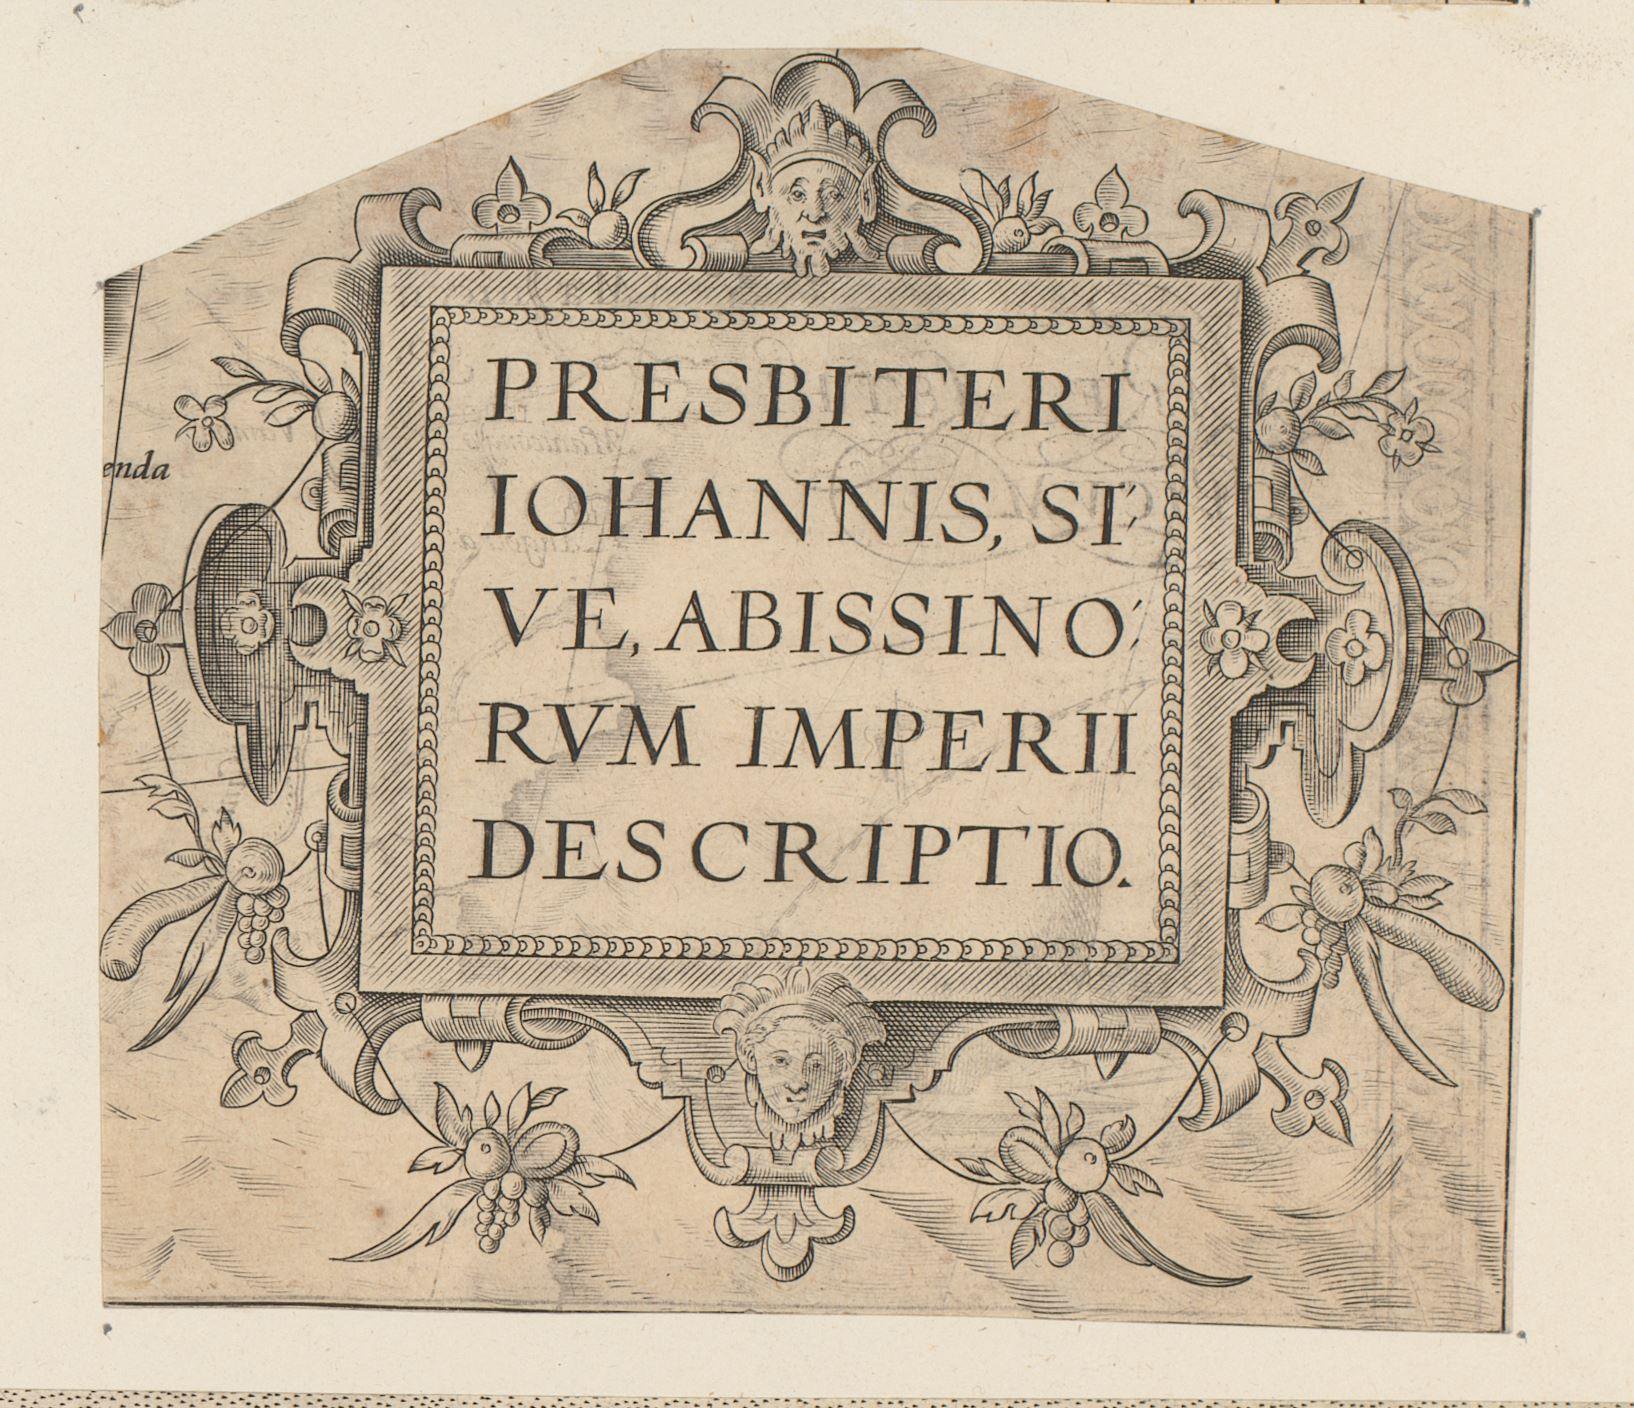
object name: album leaf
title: Cartouche van een kaart van Ethiopië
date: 1571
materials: paper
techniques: engraving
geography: antwerp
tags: fruits and vegetables ~ ornament, ornament ~ cartouche, mask, mascaron ~ ornament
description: Vierkante cartouche met maskers en trossen fruit. Het betreft een fragment van een kaart van Ethiopië. De prent maakt deel uit van een album.